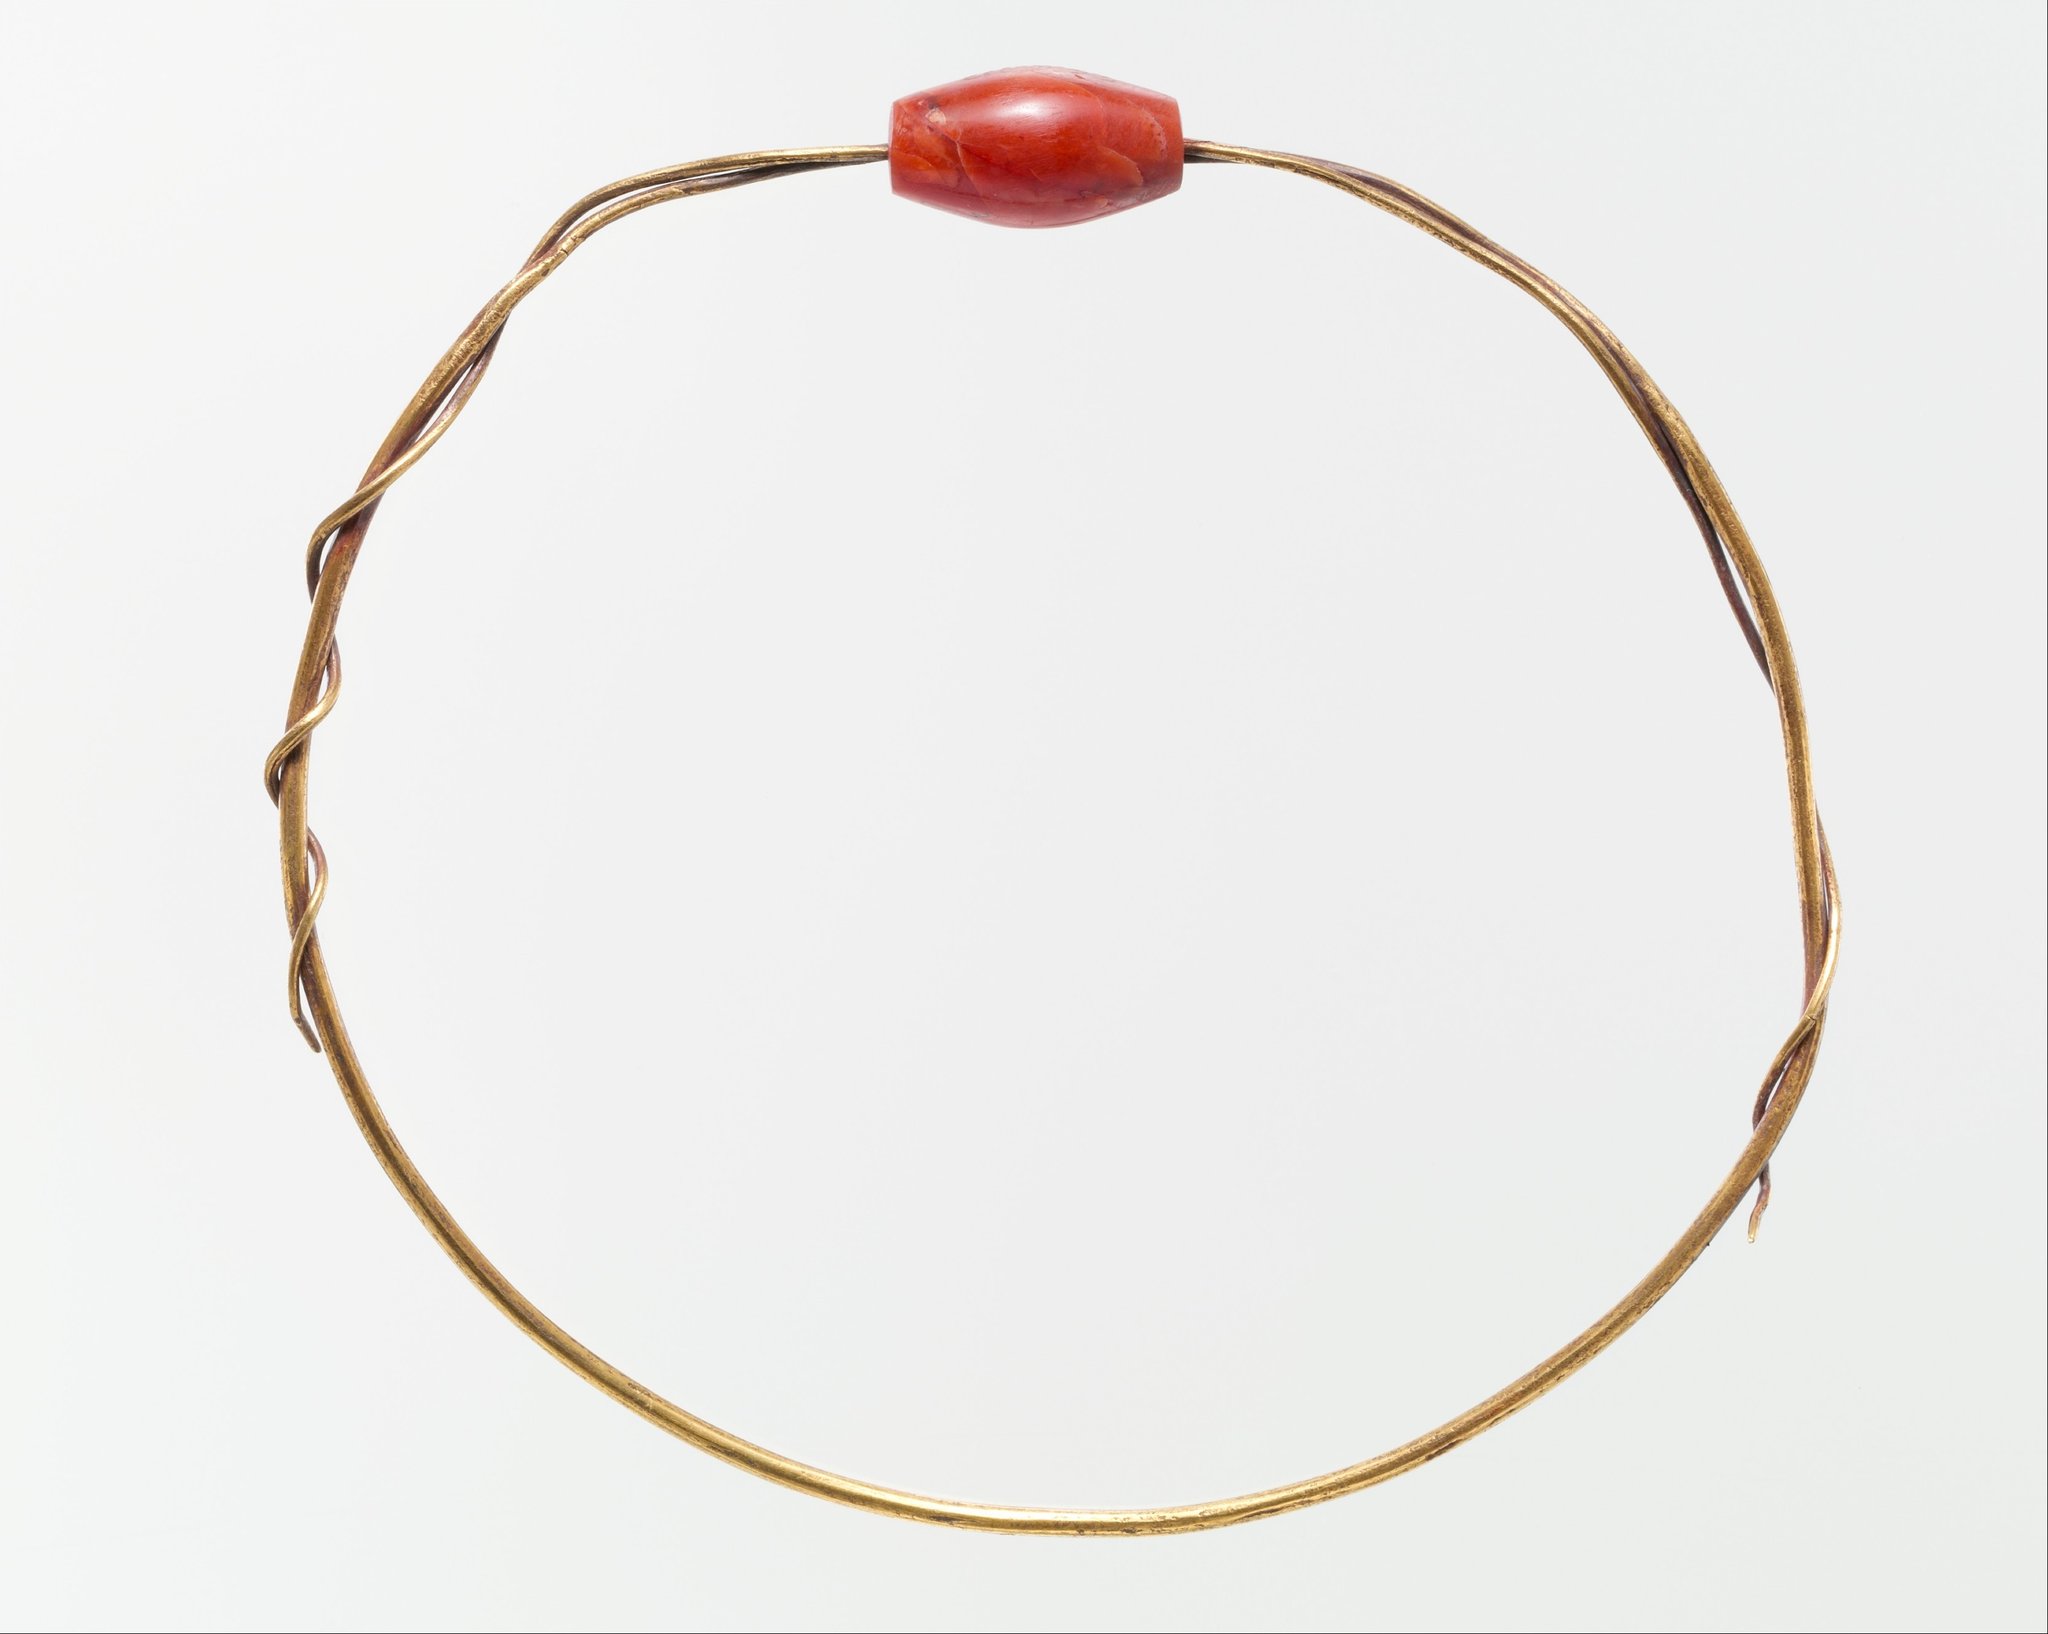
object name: torque, sweret bead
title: Sweret Bead on Gold Wire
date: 1479-1425 BCE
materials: gemstone, gold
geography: egypt